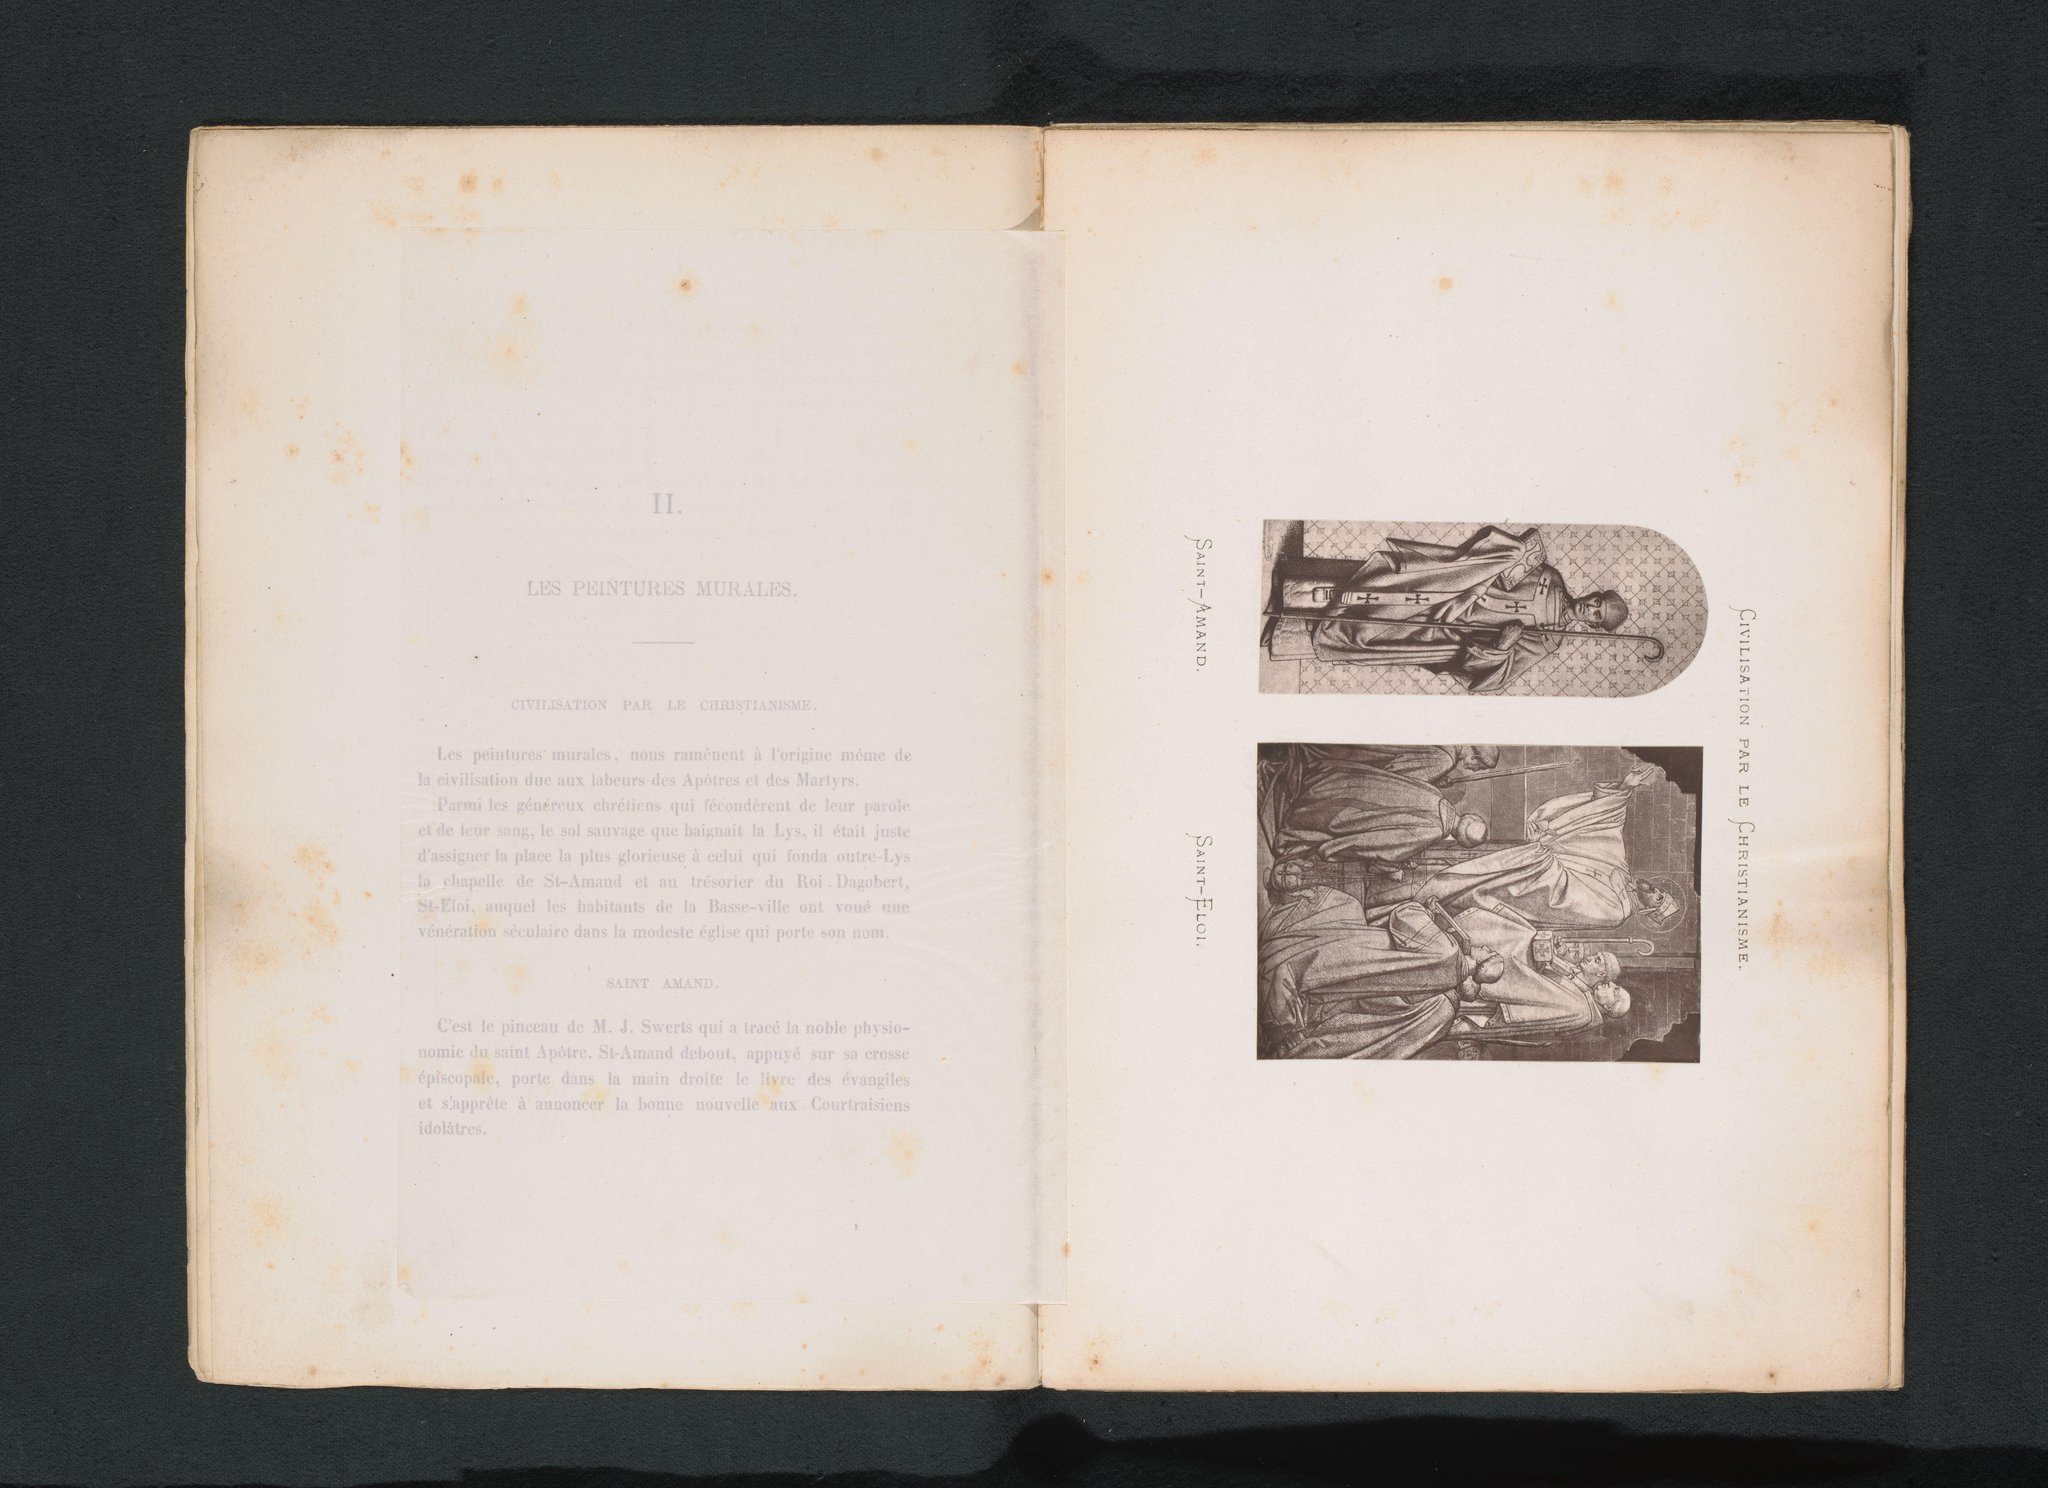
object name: reproduction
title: Reproducties van twee tekeningen naar muurschilderingen in de Schepenzaal in het Stadhuis van Kortrijk, voorstellende de heilige Amandus en de heilige Eligius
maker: Anonymous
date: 1871-1876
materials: paper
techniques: woodburytype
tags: the blacksmith and goldsmith eloi (eligius), bishop of noyon; possible attributes: anvil, cup, (crown on) hammer, horse (missing one leg), horseleg, horseshoe, tongs, amand(us) of maastricht; possible attributes: snake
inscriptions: inscription: ‘Civilisation par le Christianisme.’